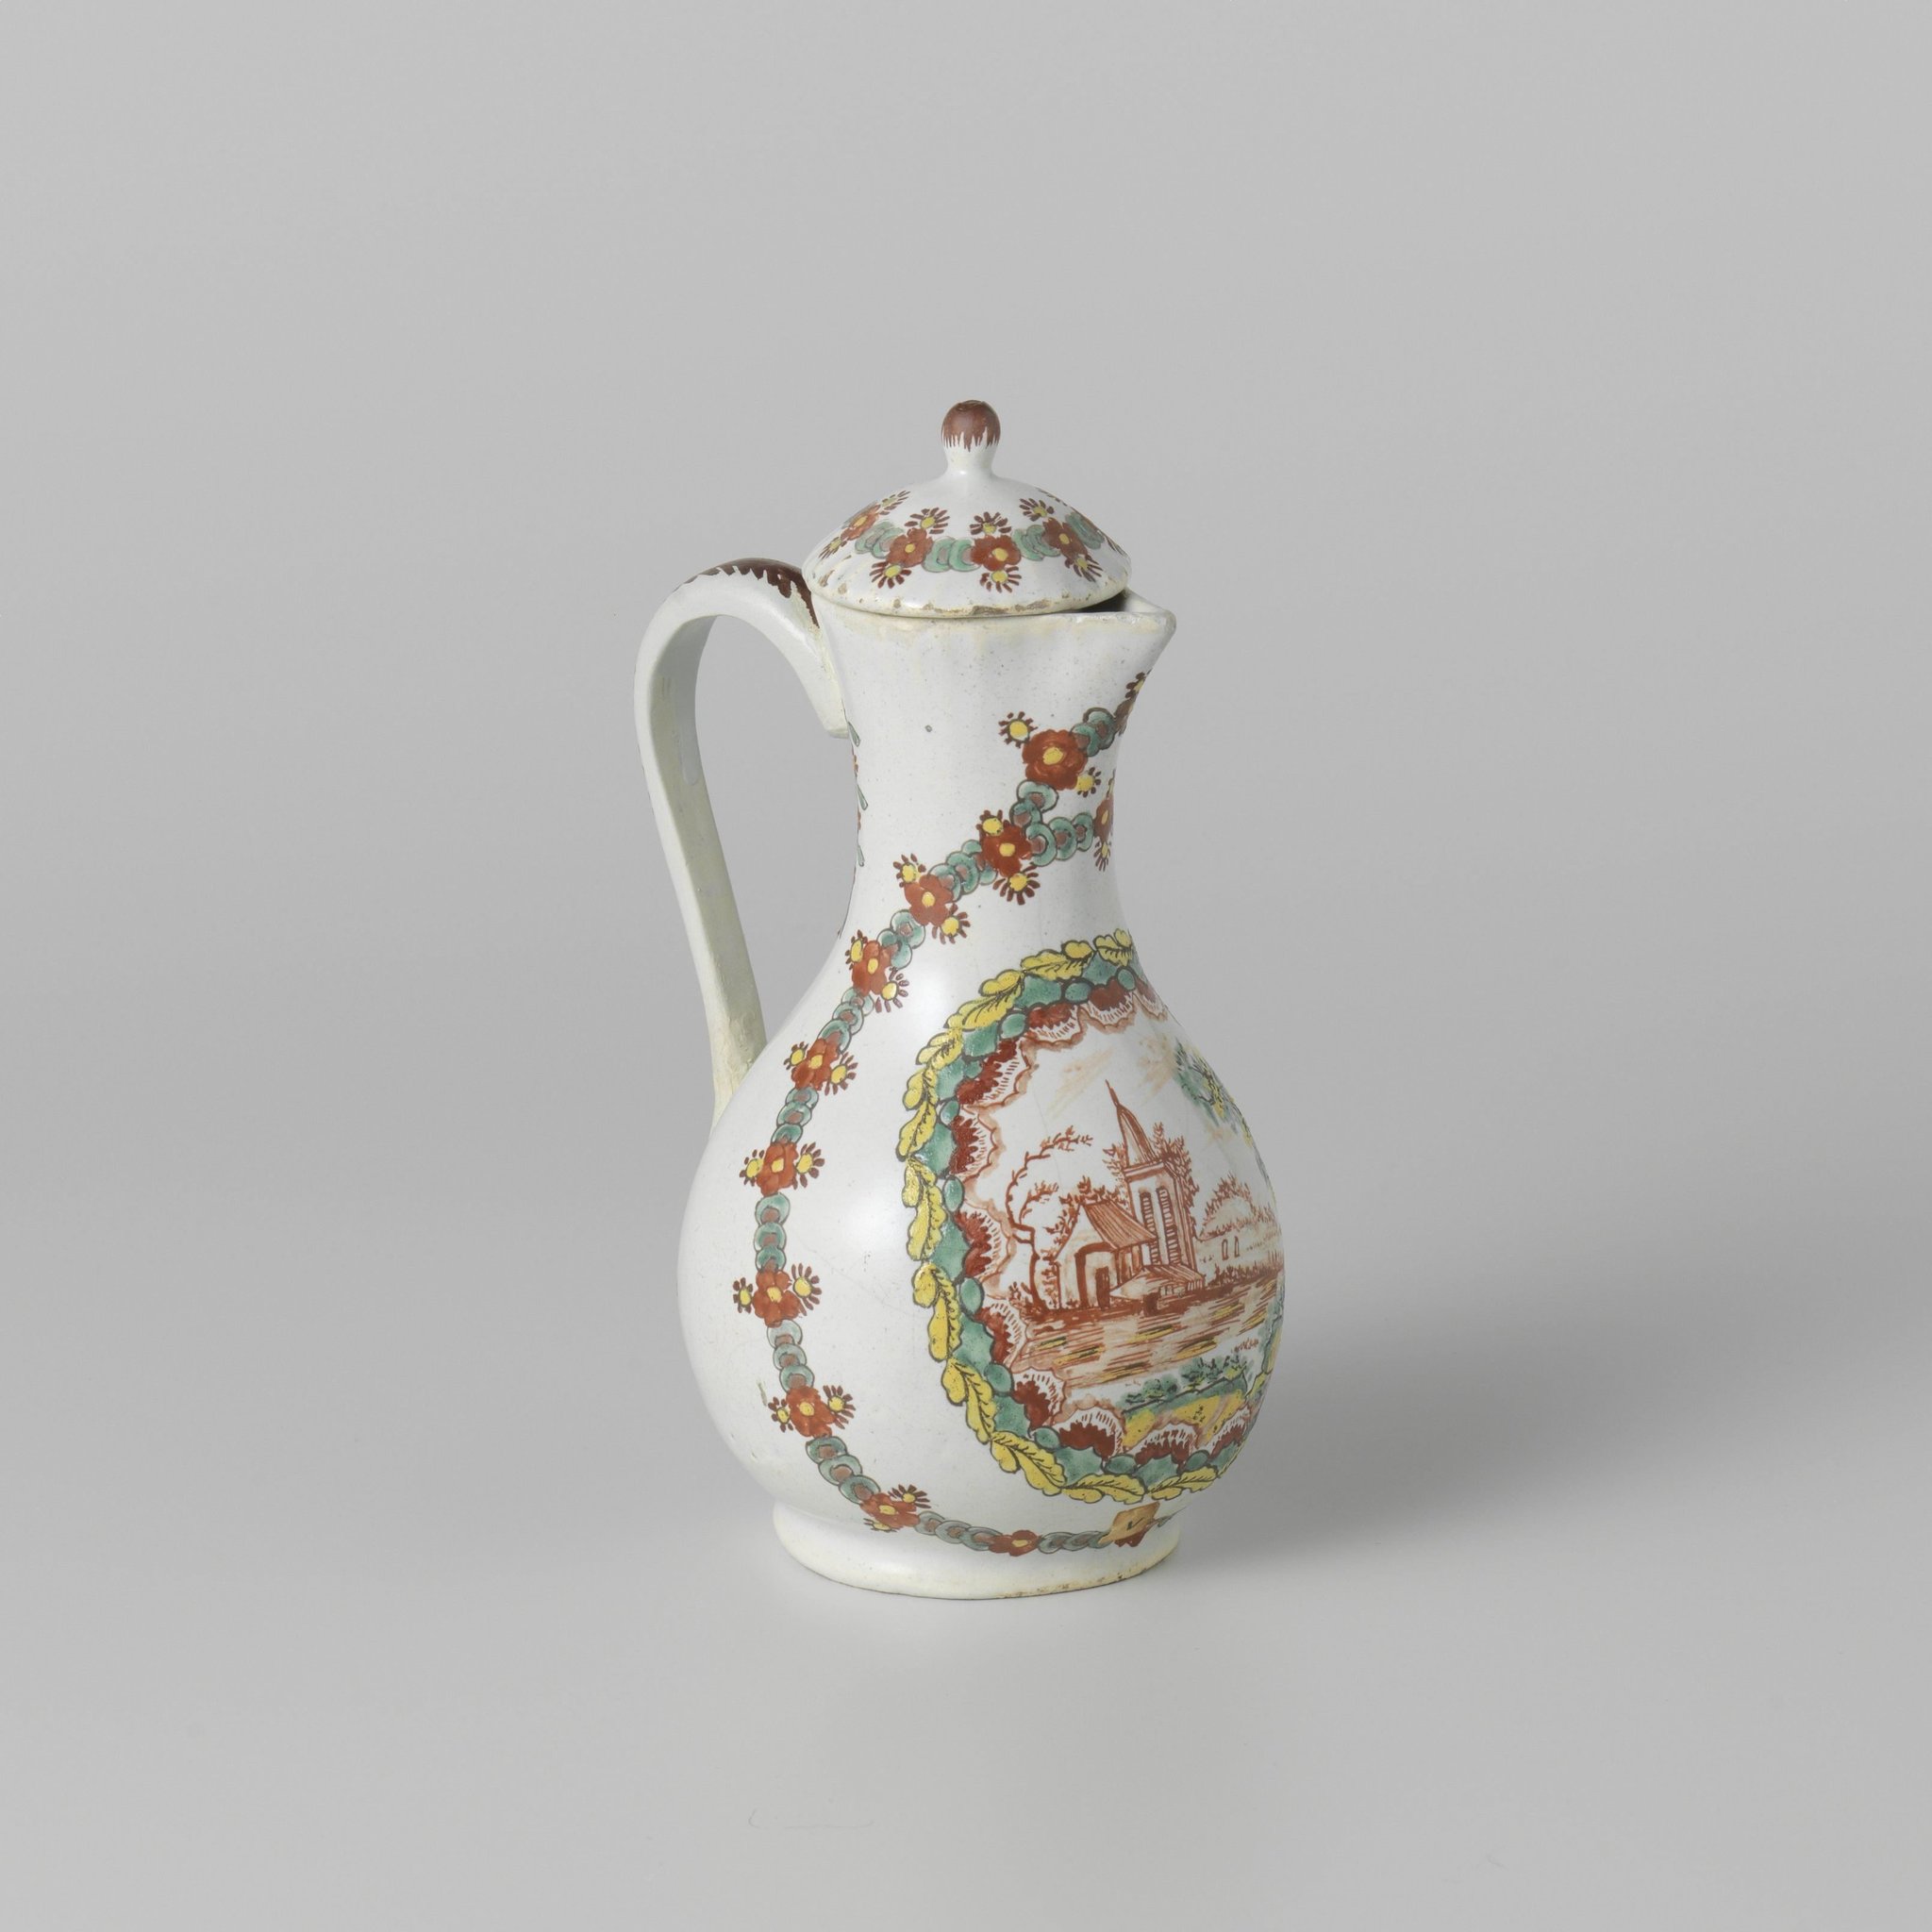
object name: milk jug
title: Melkkan met deksel van veelkleurig beschilderde faïence met decor van een landschap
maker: Anonymous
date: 1760-1790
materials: faience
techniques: kiln, painted, polychromy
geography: delft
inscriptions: inscription: ‘[...] /F=’, inscription: ‘V’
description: Melkkan met deksel van veelkleurig beschilderde faïence met een decor van een landschap binnen een krans.